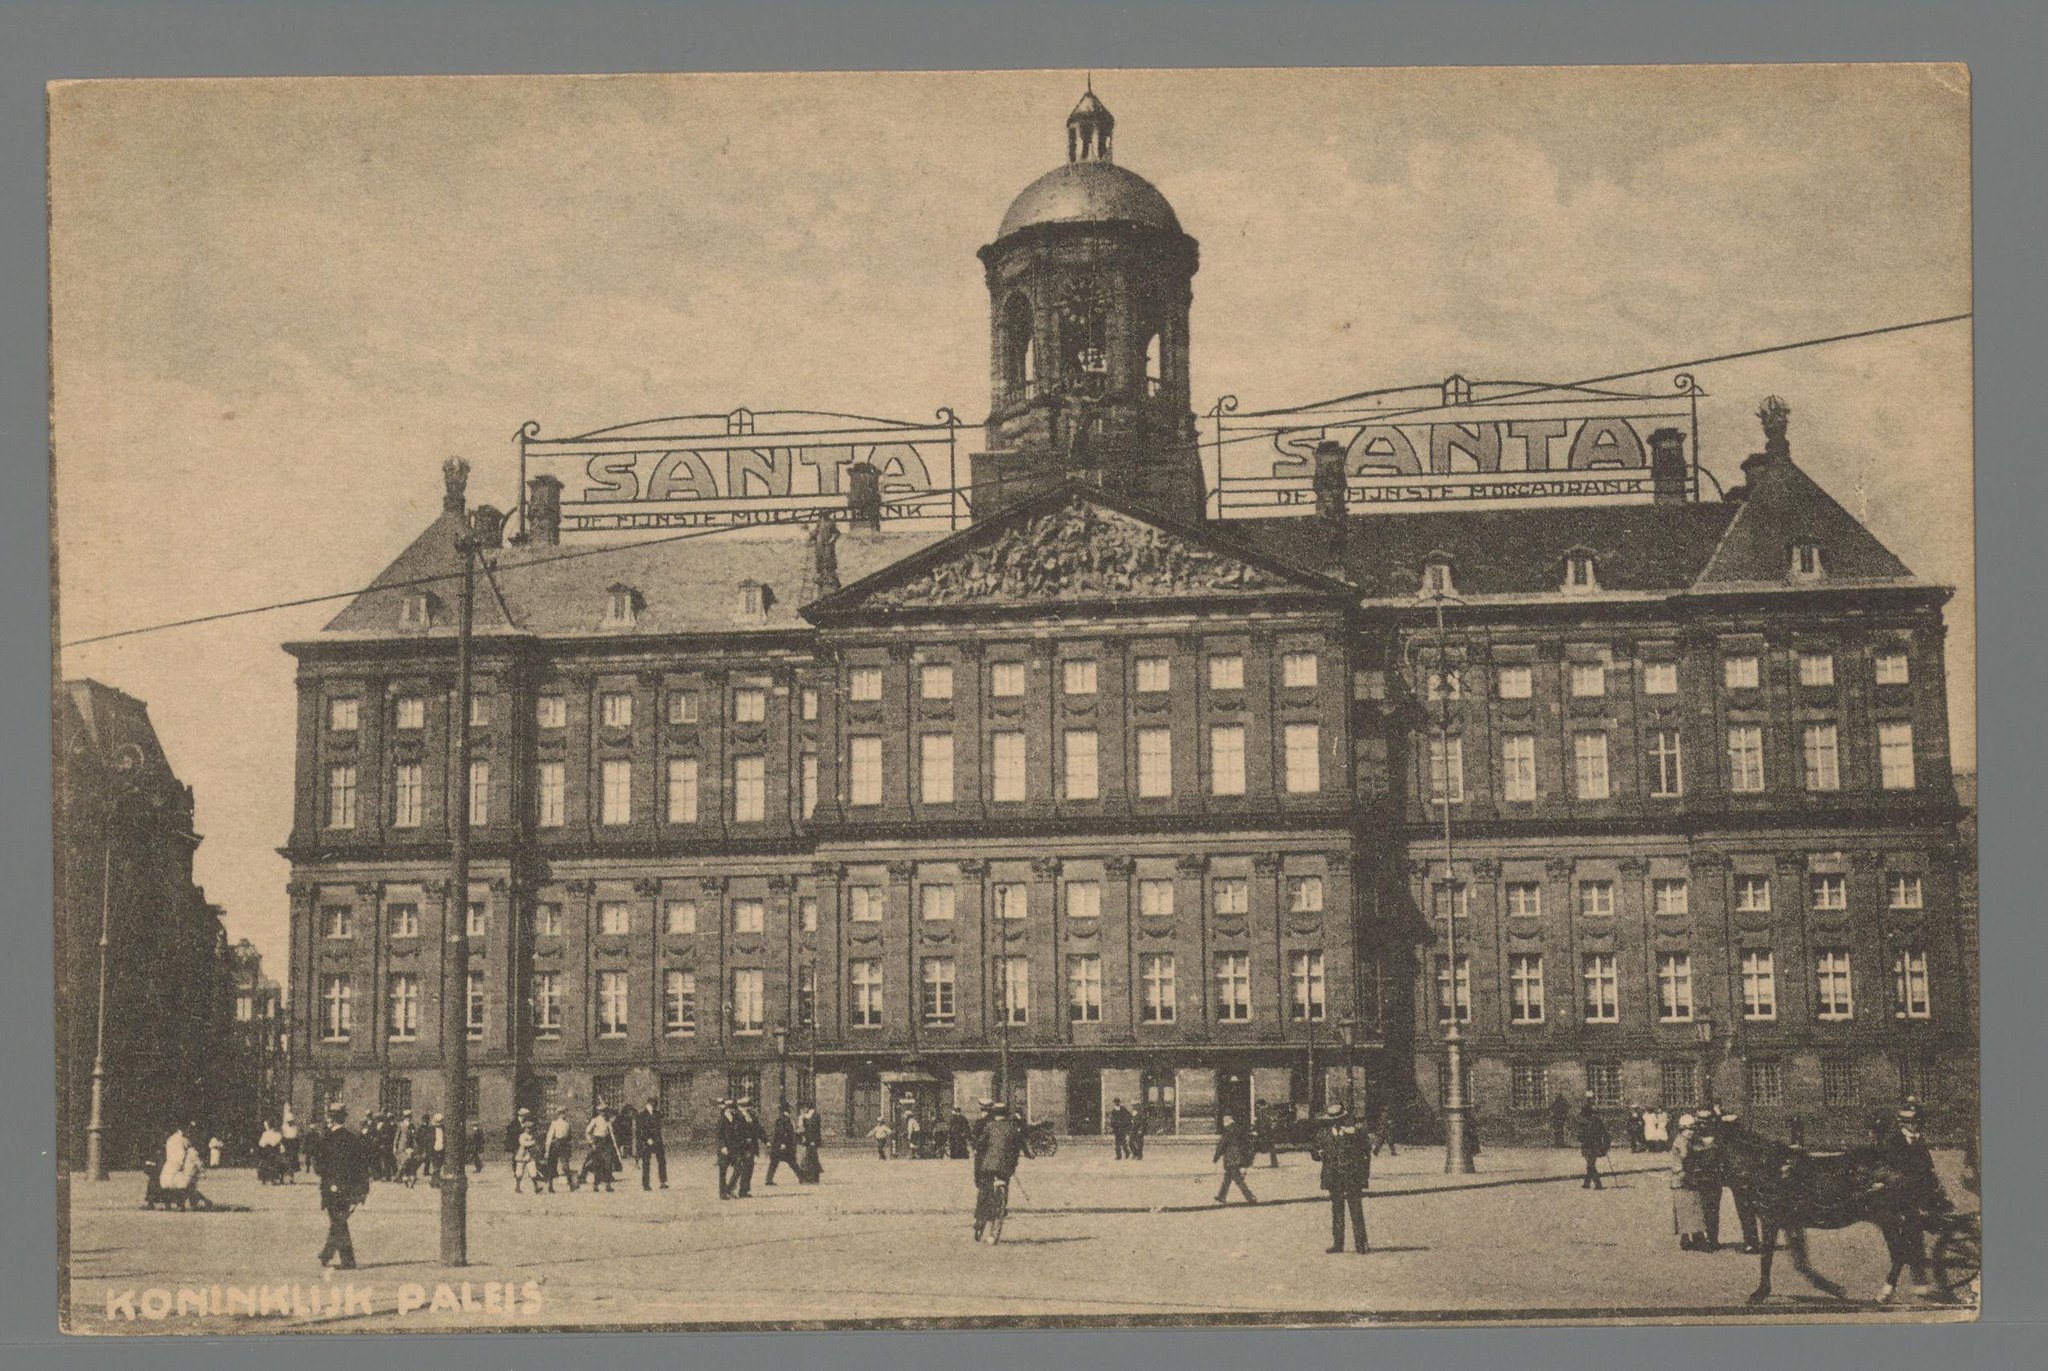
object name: ansichtkaart, prentbriefkaart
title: Koninklijk Paleis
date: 1915-1930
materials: cardboard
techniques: photograph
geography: amsterdam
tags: city-view, and landscape with man-made constructions, palace, royal palace of amsterdam, amsterdam